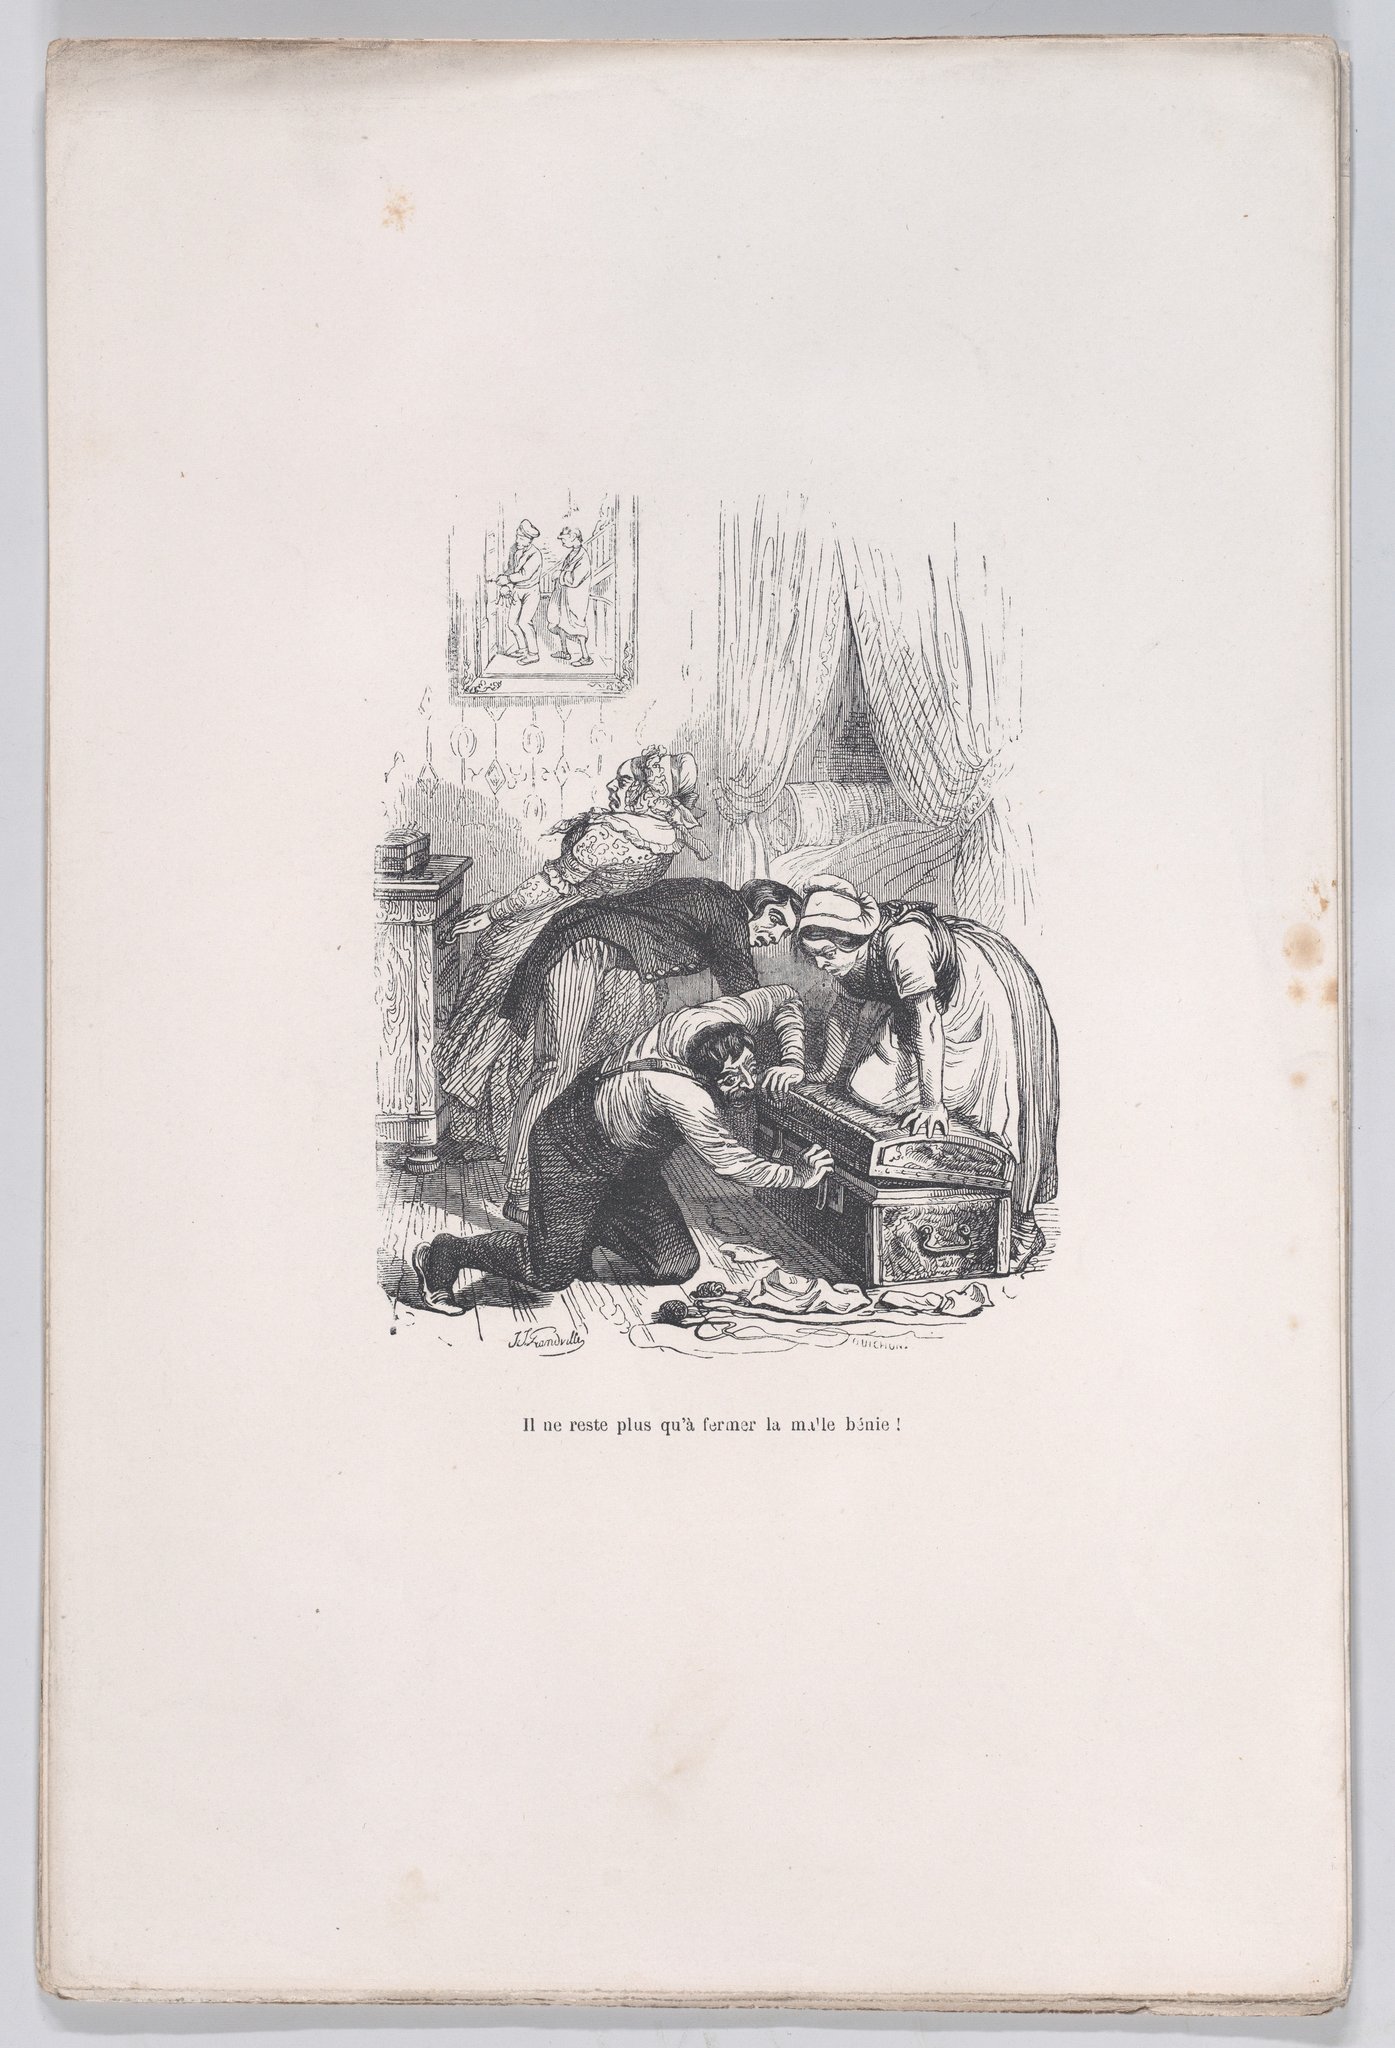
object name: print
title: All that remains is to close the blessed trunk!, from "Little Miseries of Human Life"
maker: j. j. grandville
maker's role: illustrator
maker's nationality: french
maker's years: 1803-1847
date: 1843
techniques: engraving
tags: men,women,beds